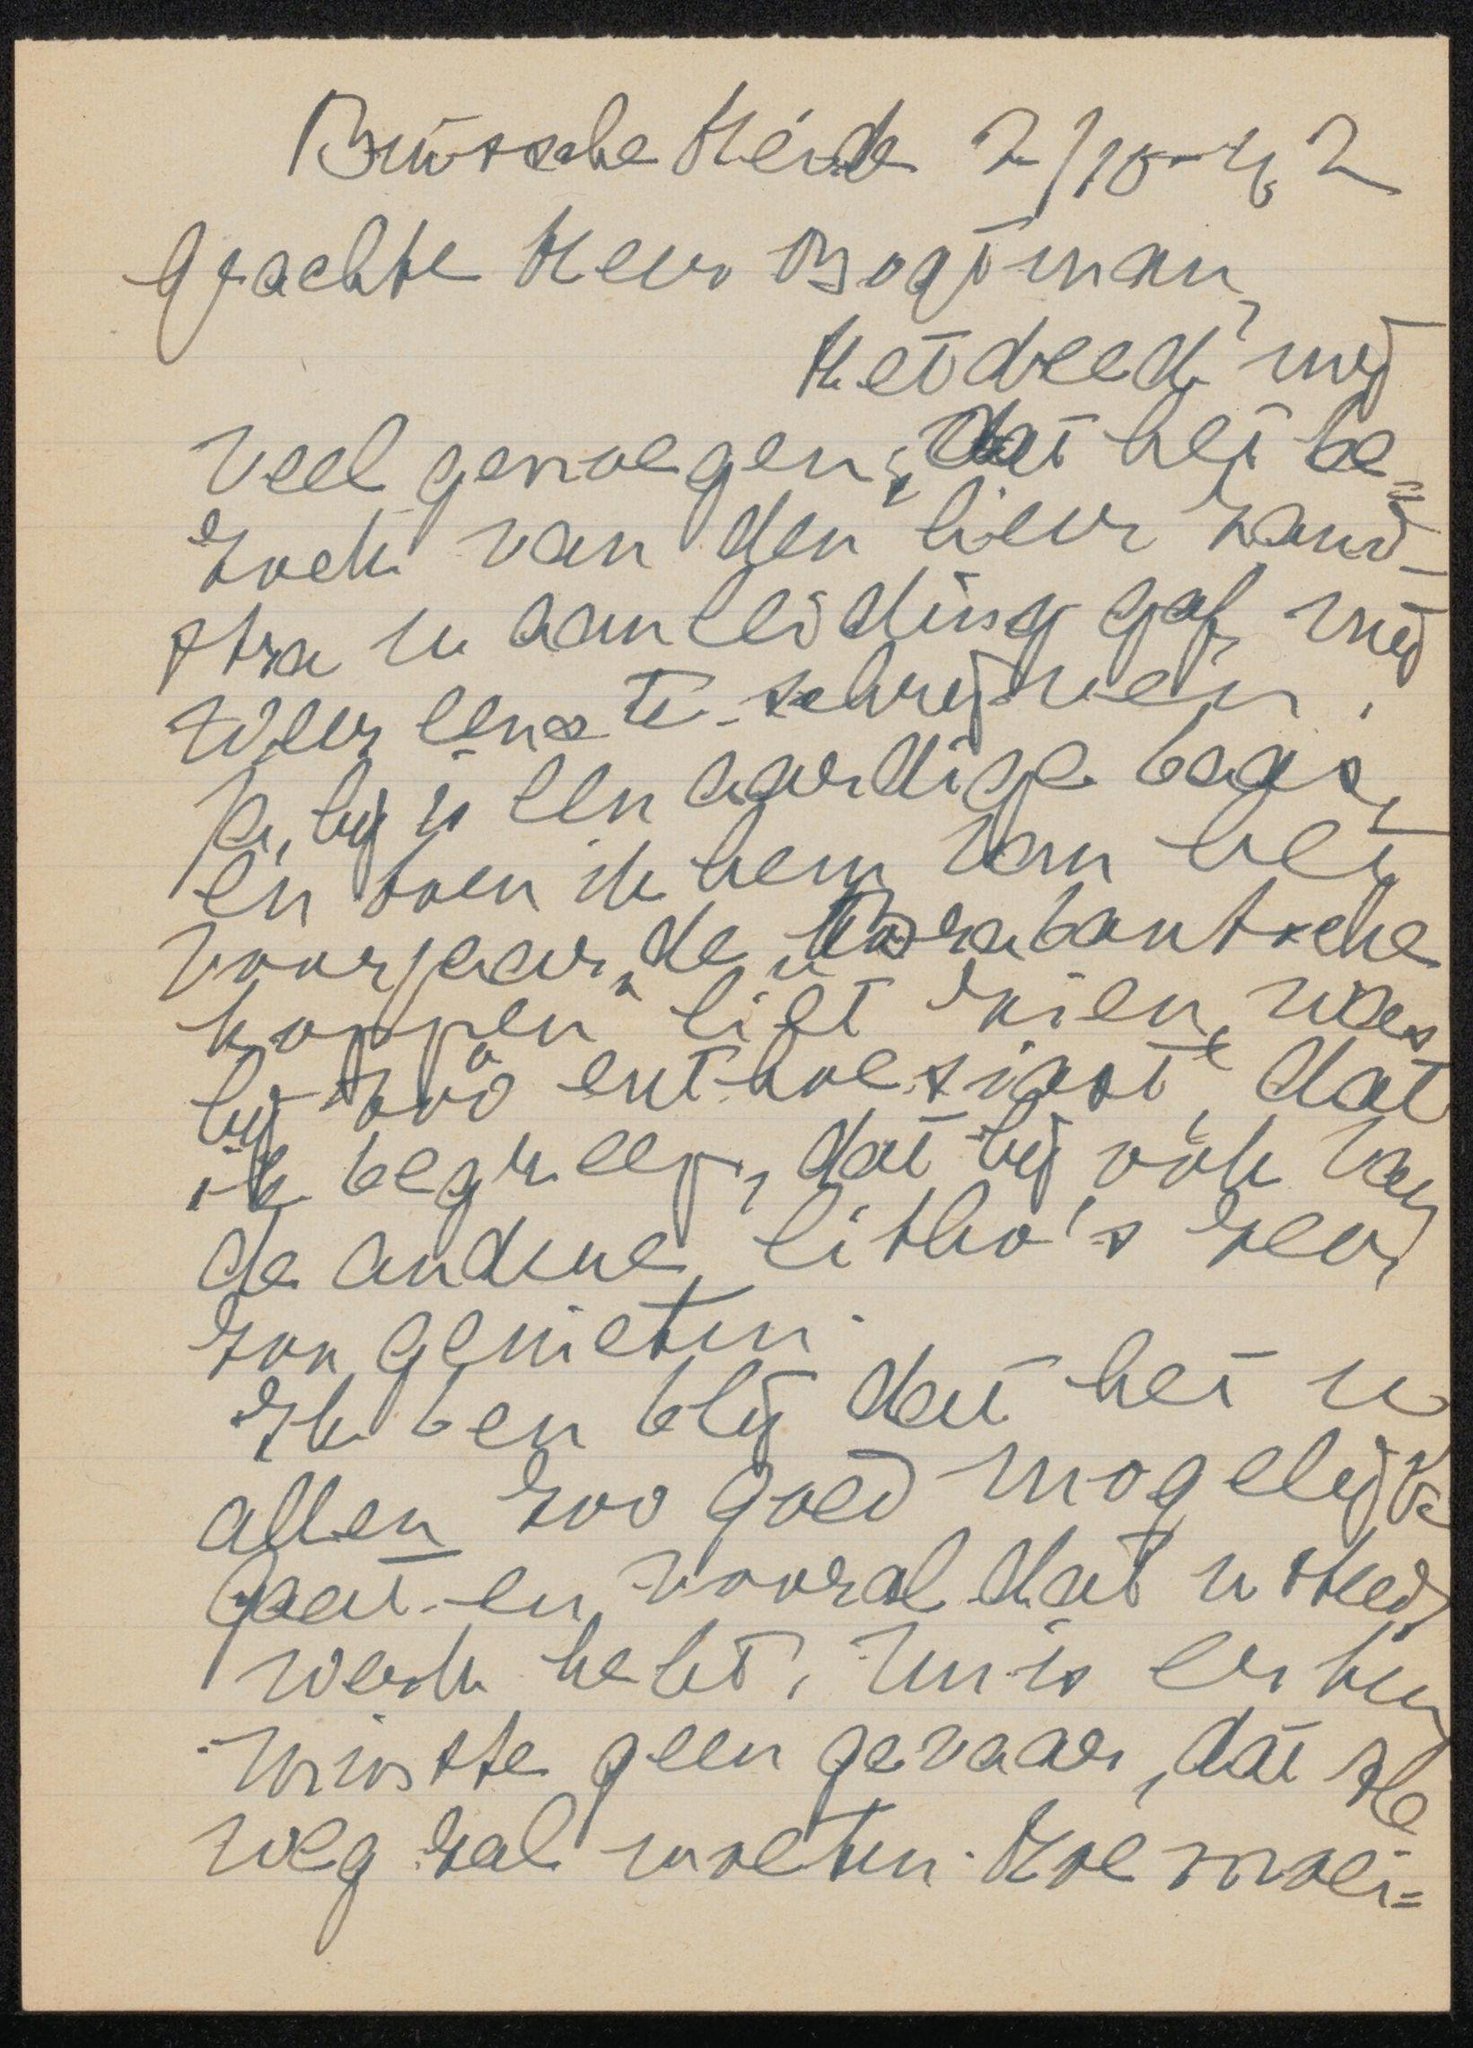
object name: letter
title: Brief aan Willem Bogtman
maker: henriëtte roland holst-van der schalk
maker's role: dichter, schrijver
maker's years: 1869-1952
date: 1942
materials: ink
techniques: pen, writing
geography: buissche heide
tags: print maker, toos bogtman, haarlem, willem bogtman, applied arts, arts and crafts; industrial design, the graphic arts, amsterdam